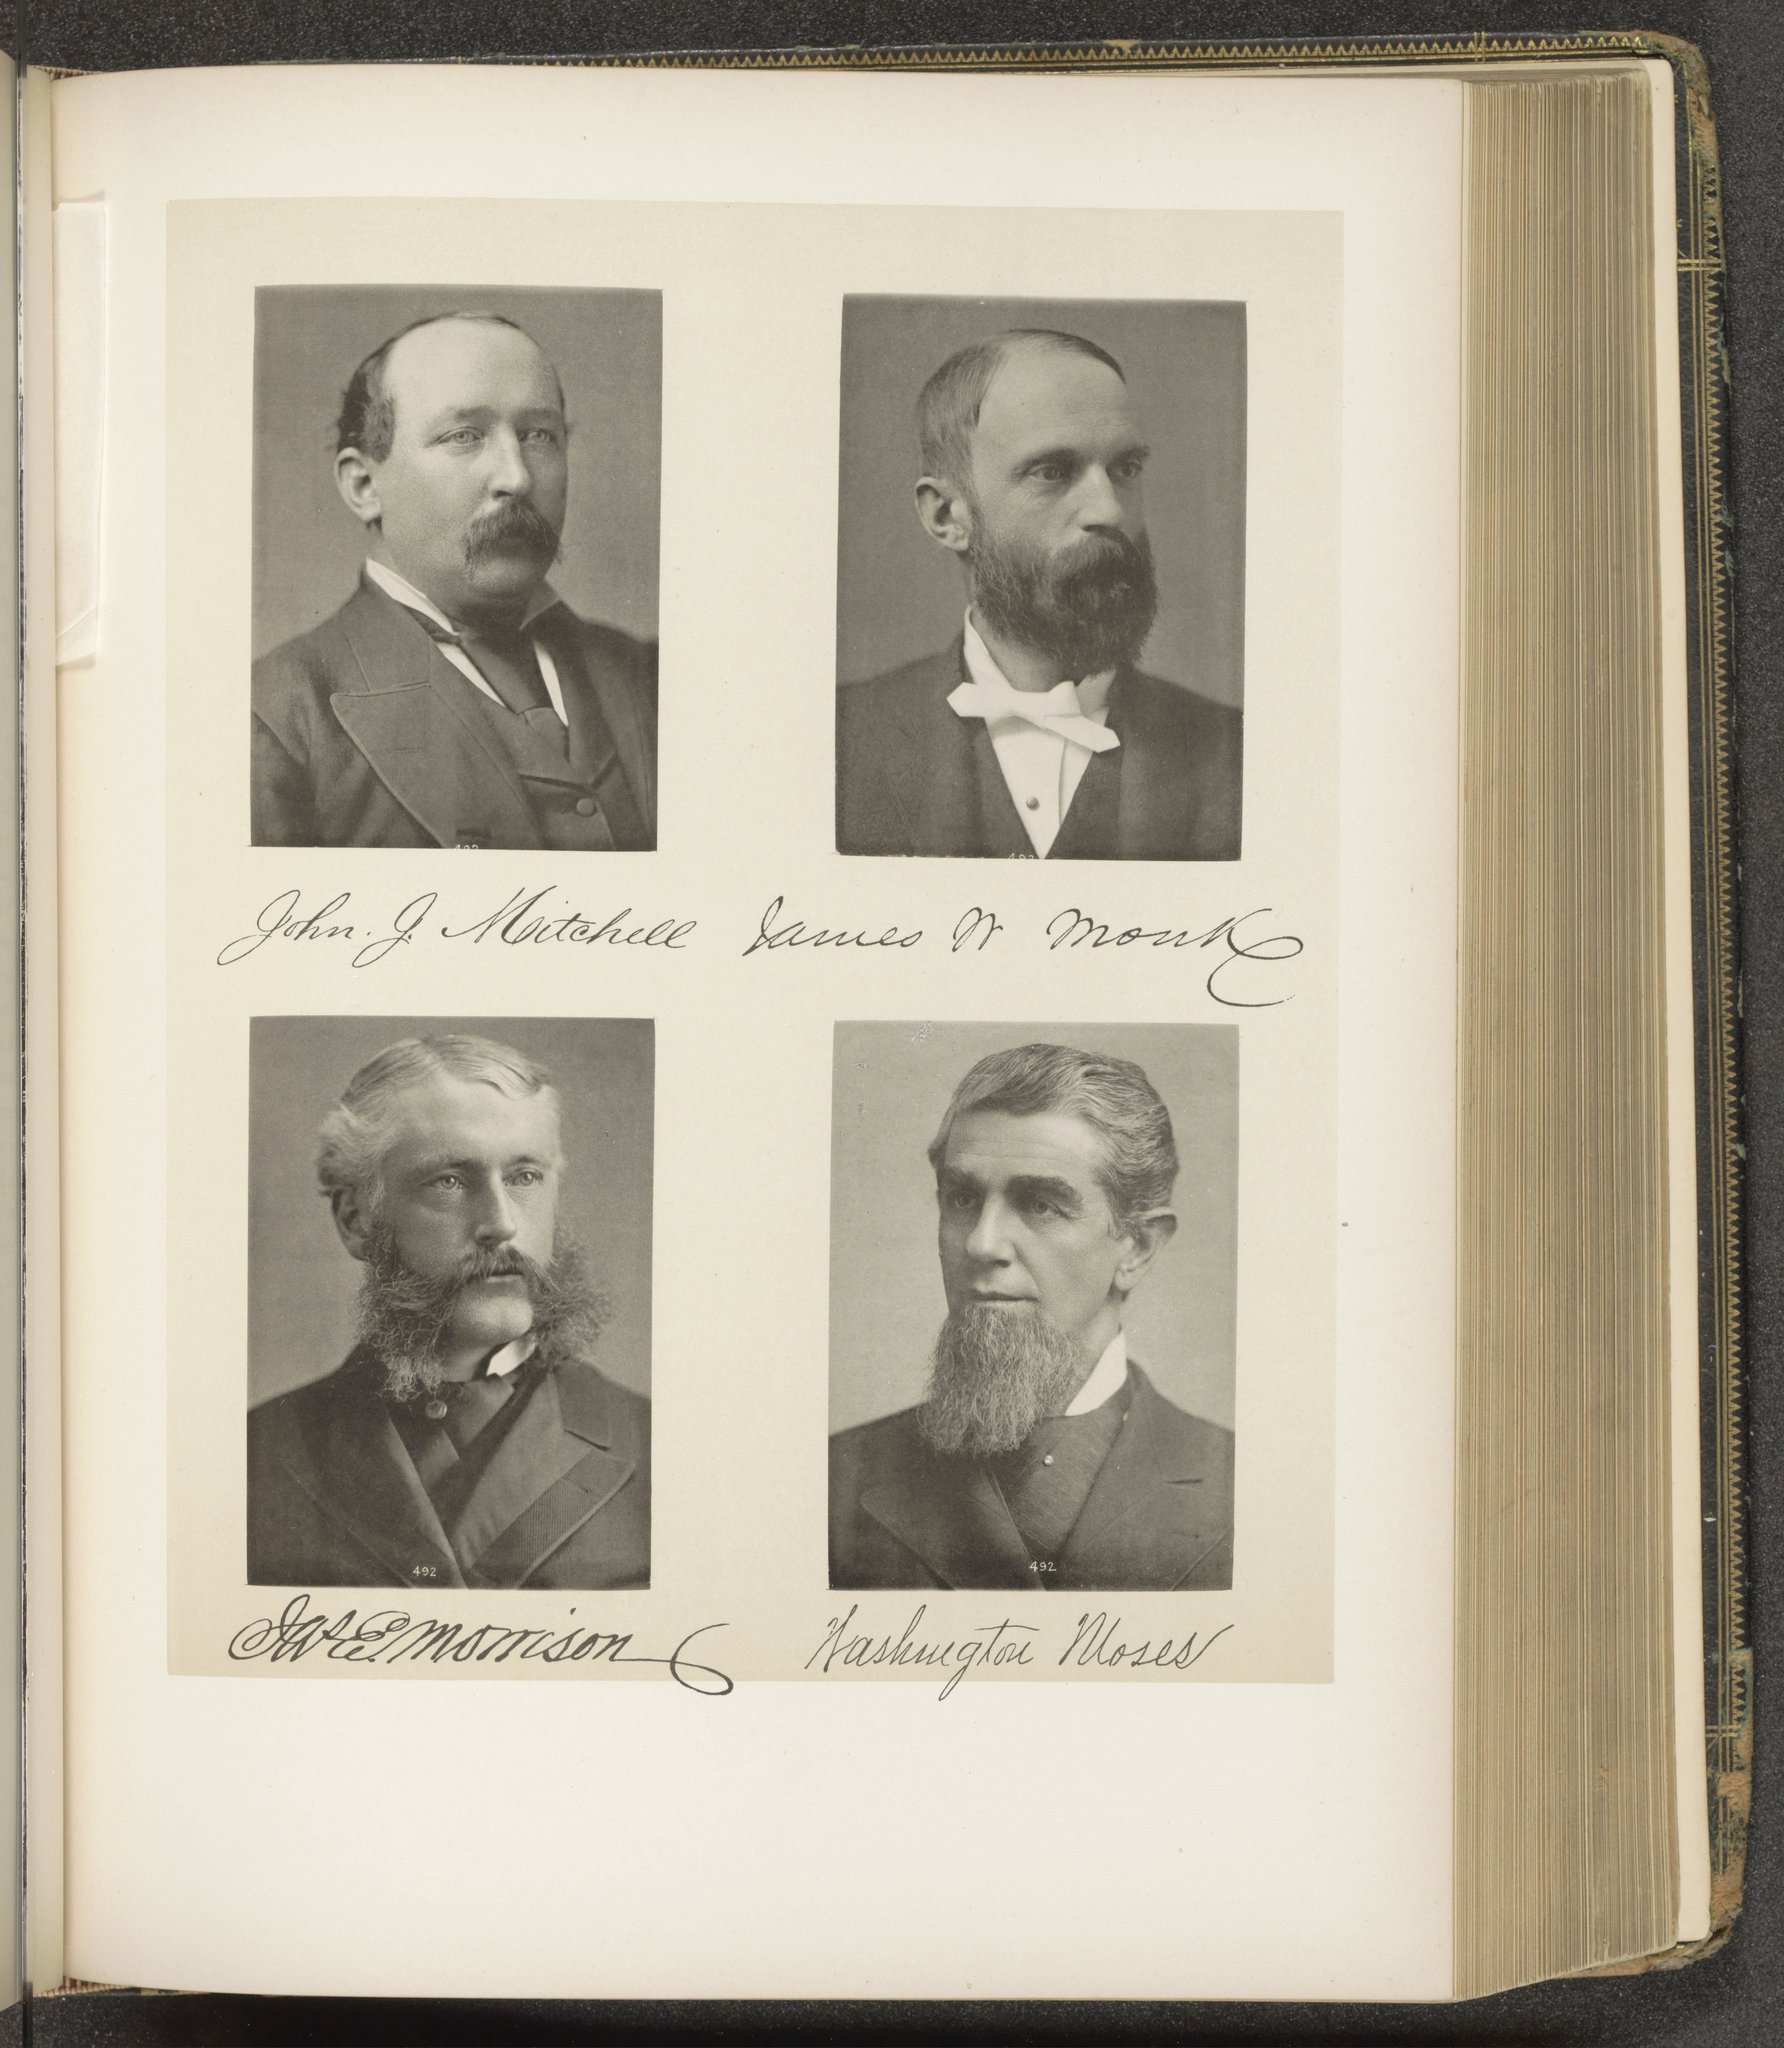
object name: photomechanical print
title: Portretten van vier leden van het Lagerhuis van de staat New York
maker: Anonymous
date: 1872-1882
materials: paper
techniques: photograph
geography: united states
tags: historical persons (portraits and scenes from the life) (+ head (and shoulders) (portrait))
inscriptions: annotation, number: ‘492’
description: Linksboven John J. Mitchell, rechtsboven James W. Monk, linksonder James Edward Morrison, rechtsonder Washington Moses.